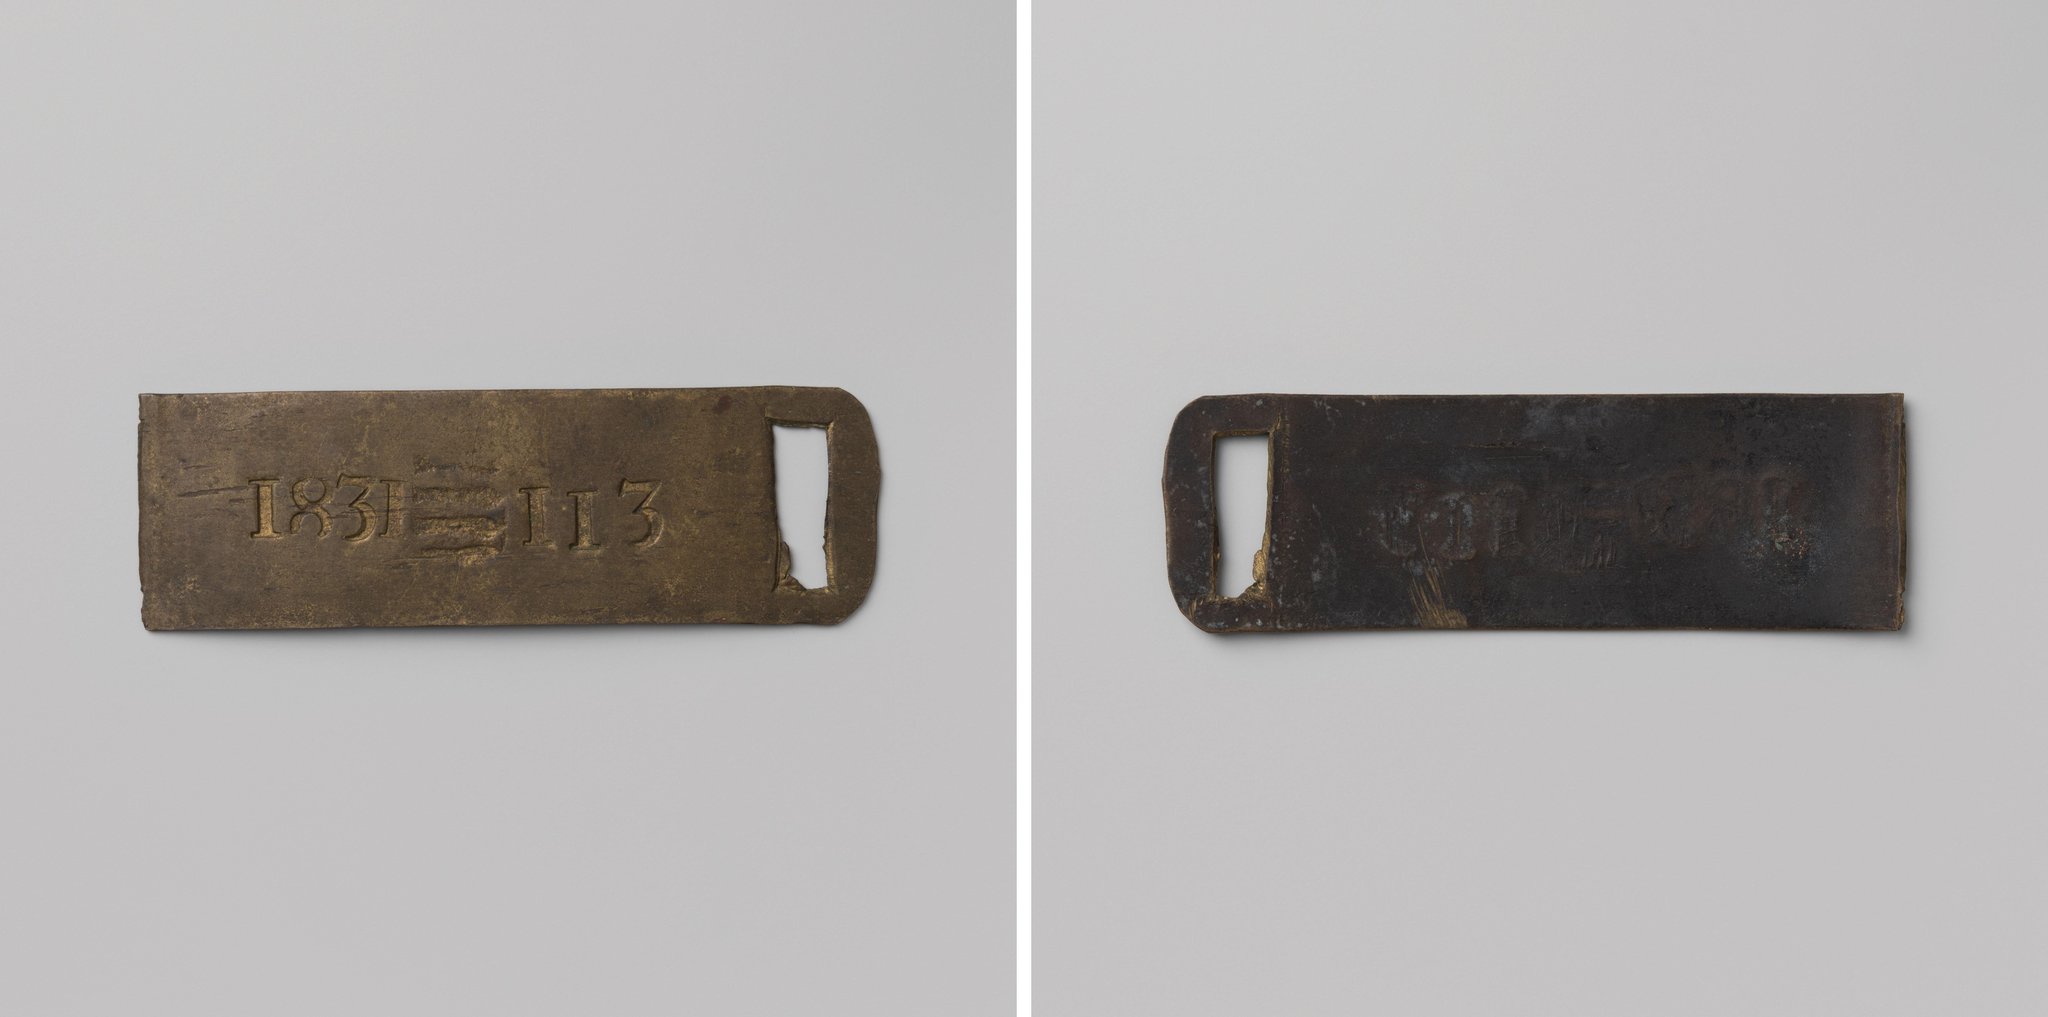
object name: tax token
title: Stad Enkhuizen, loodje met no. 113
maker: Anonymous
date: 1831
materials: brass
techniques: striking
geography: enkhuizen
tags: enkhuizen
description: Eenzijdig, staafvormig messing loodje met aan rechterzijde rechthoekige uitsparing. Voorzijde: wapenschild met ter linkerzijde jaartal, ter rechterzijde cijfer 113. Keerzijde: blanco.